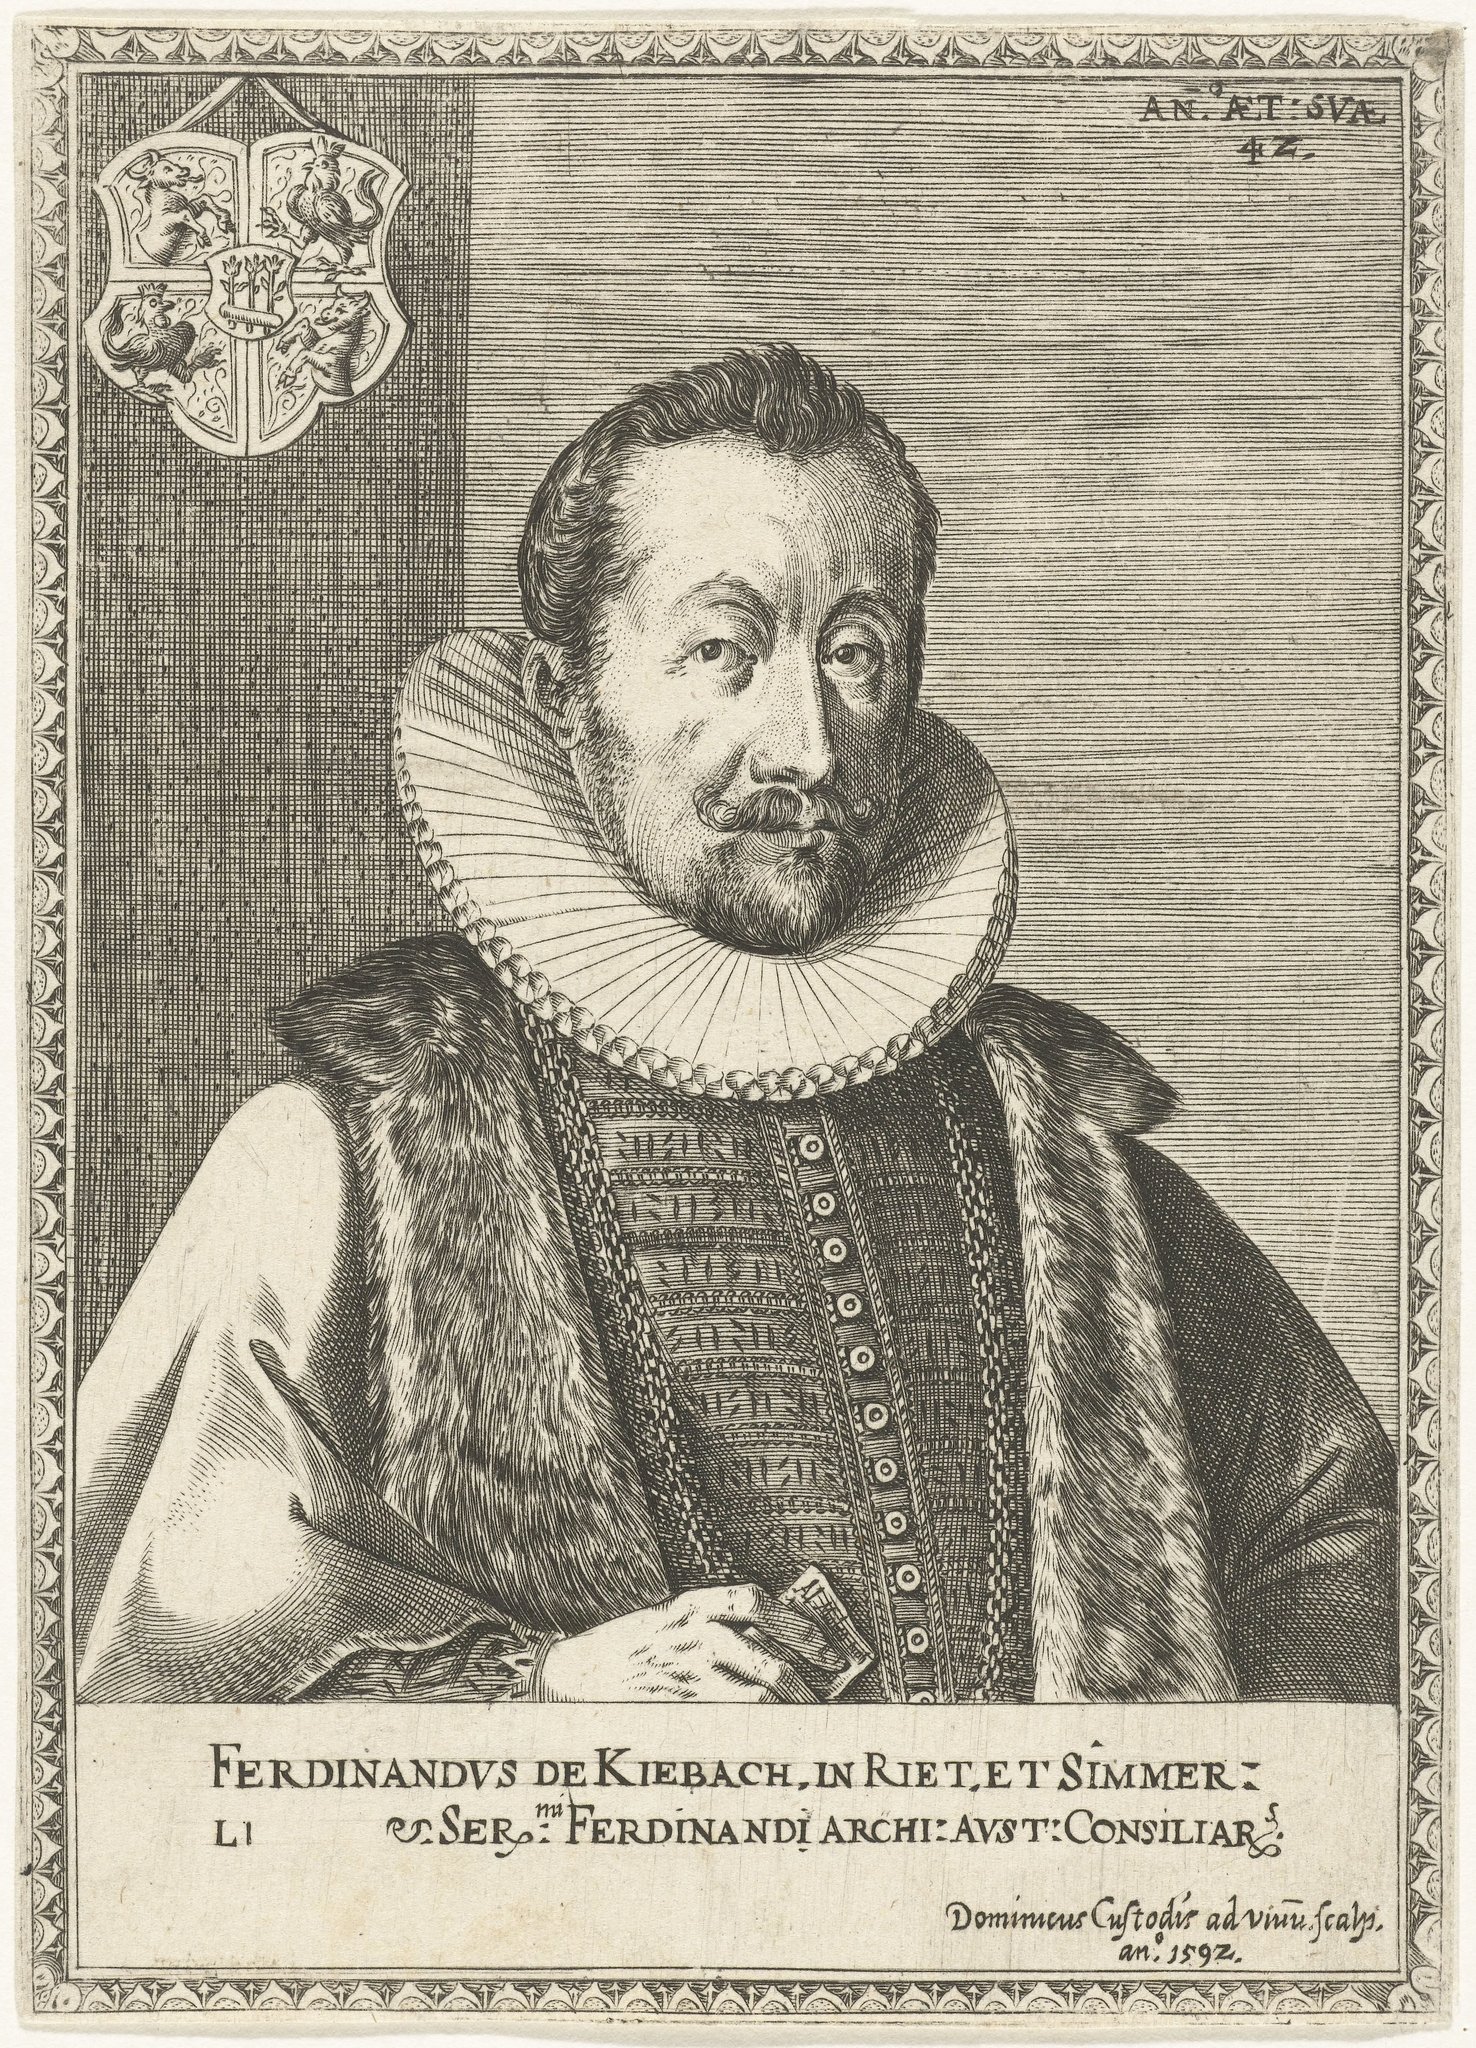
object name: print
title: Portret van Ferdinand van Kiebach te Ried op 42-jarige leeftijd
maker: dominicus custos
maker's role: print maker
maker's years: 1560-1615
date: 1592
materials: paper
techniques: engraving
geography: augsburg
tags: ferdinand van kiebach te ried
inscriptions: collector's mark: Lugt 2228